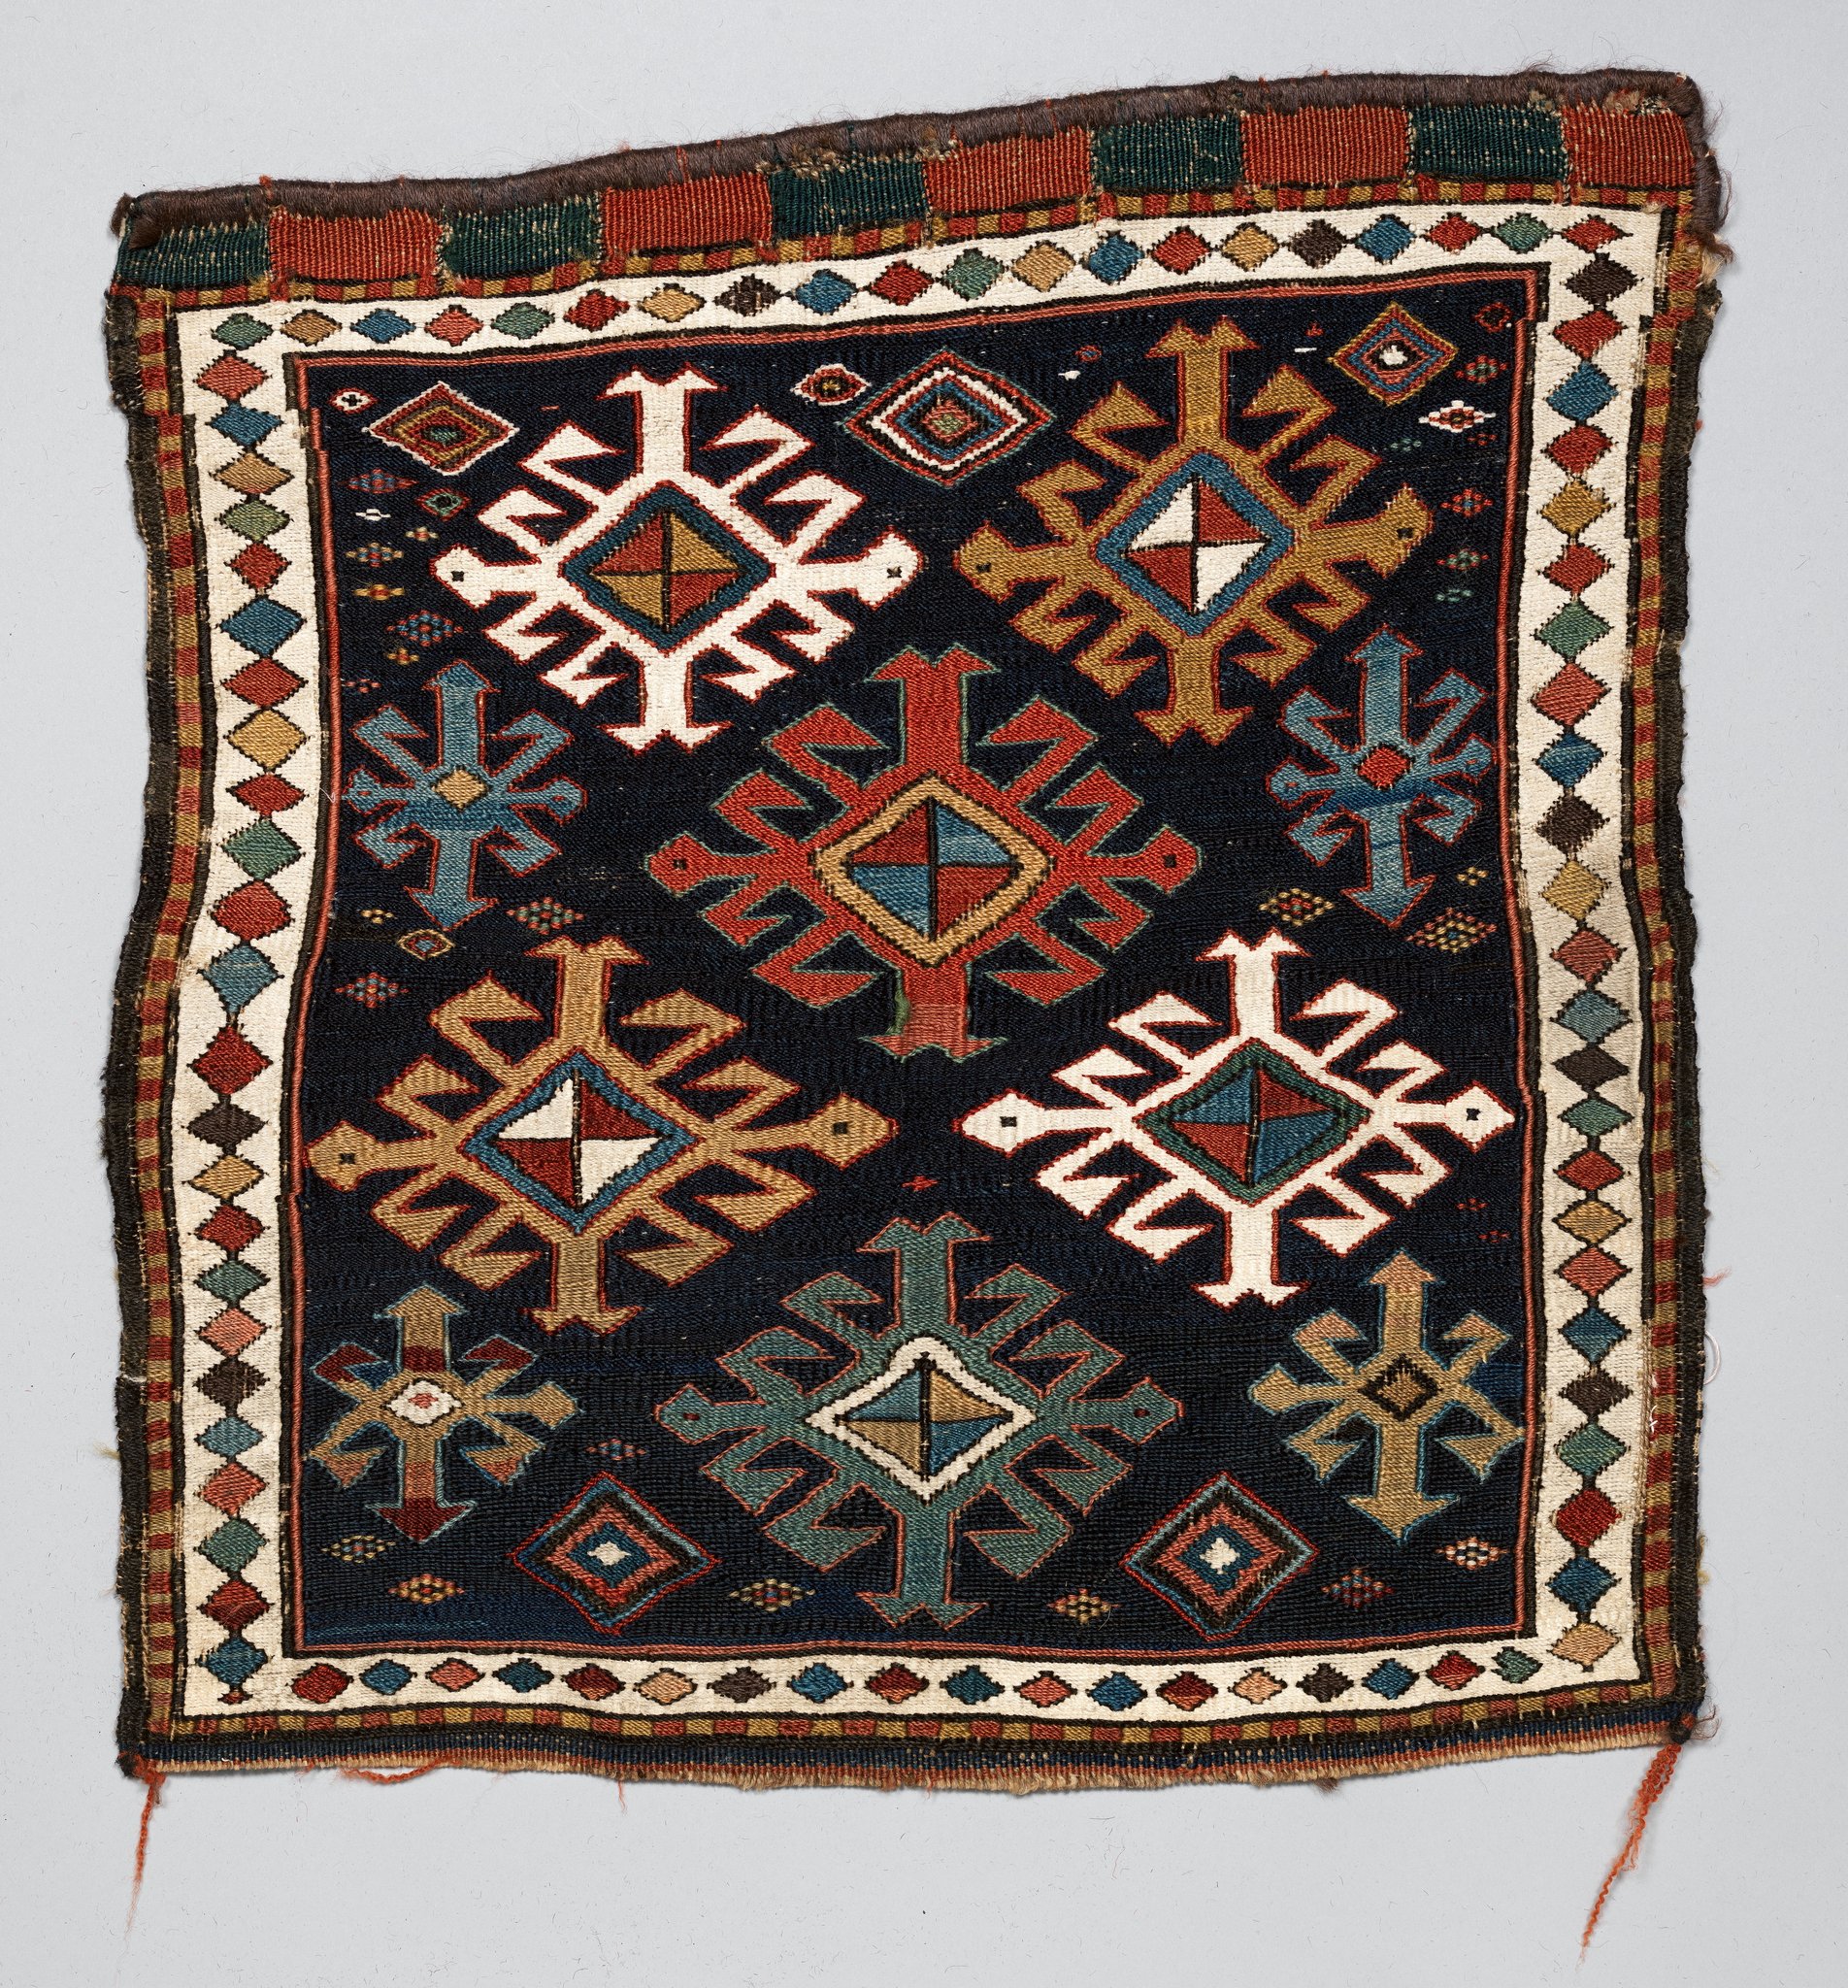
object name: saddle bag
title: Half of Double Saddle Bag (Khorjin)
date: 1870-1900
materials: cotton, wool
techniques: brocade, weave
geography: iran